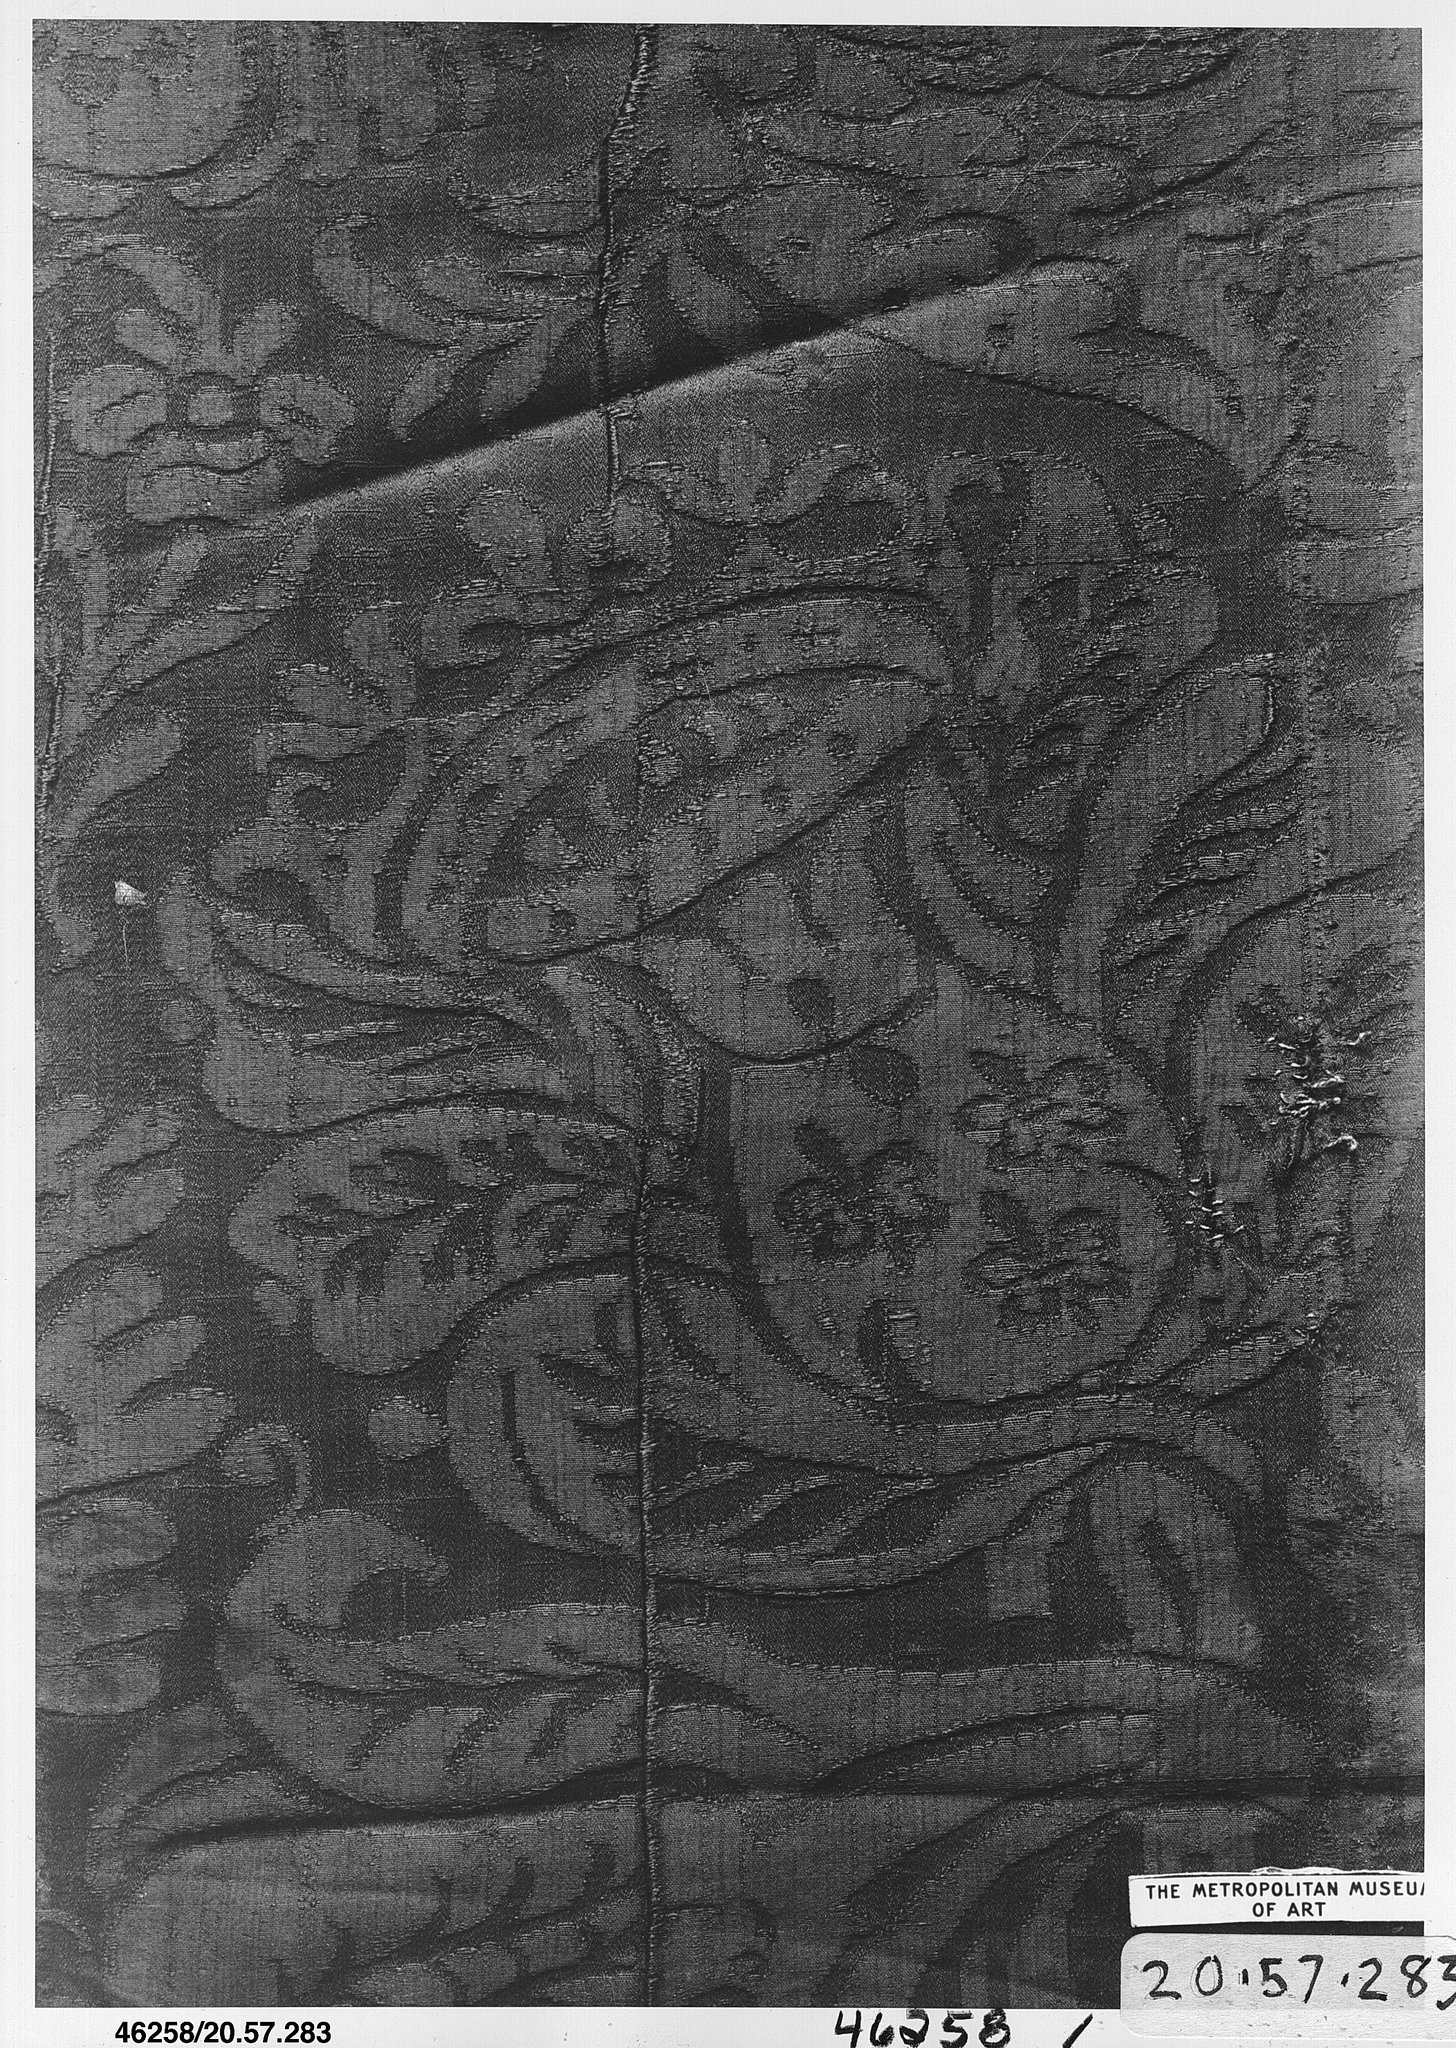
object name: piece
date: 1601-1700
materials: silk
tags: flowers,leaves